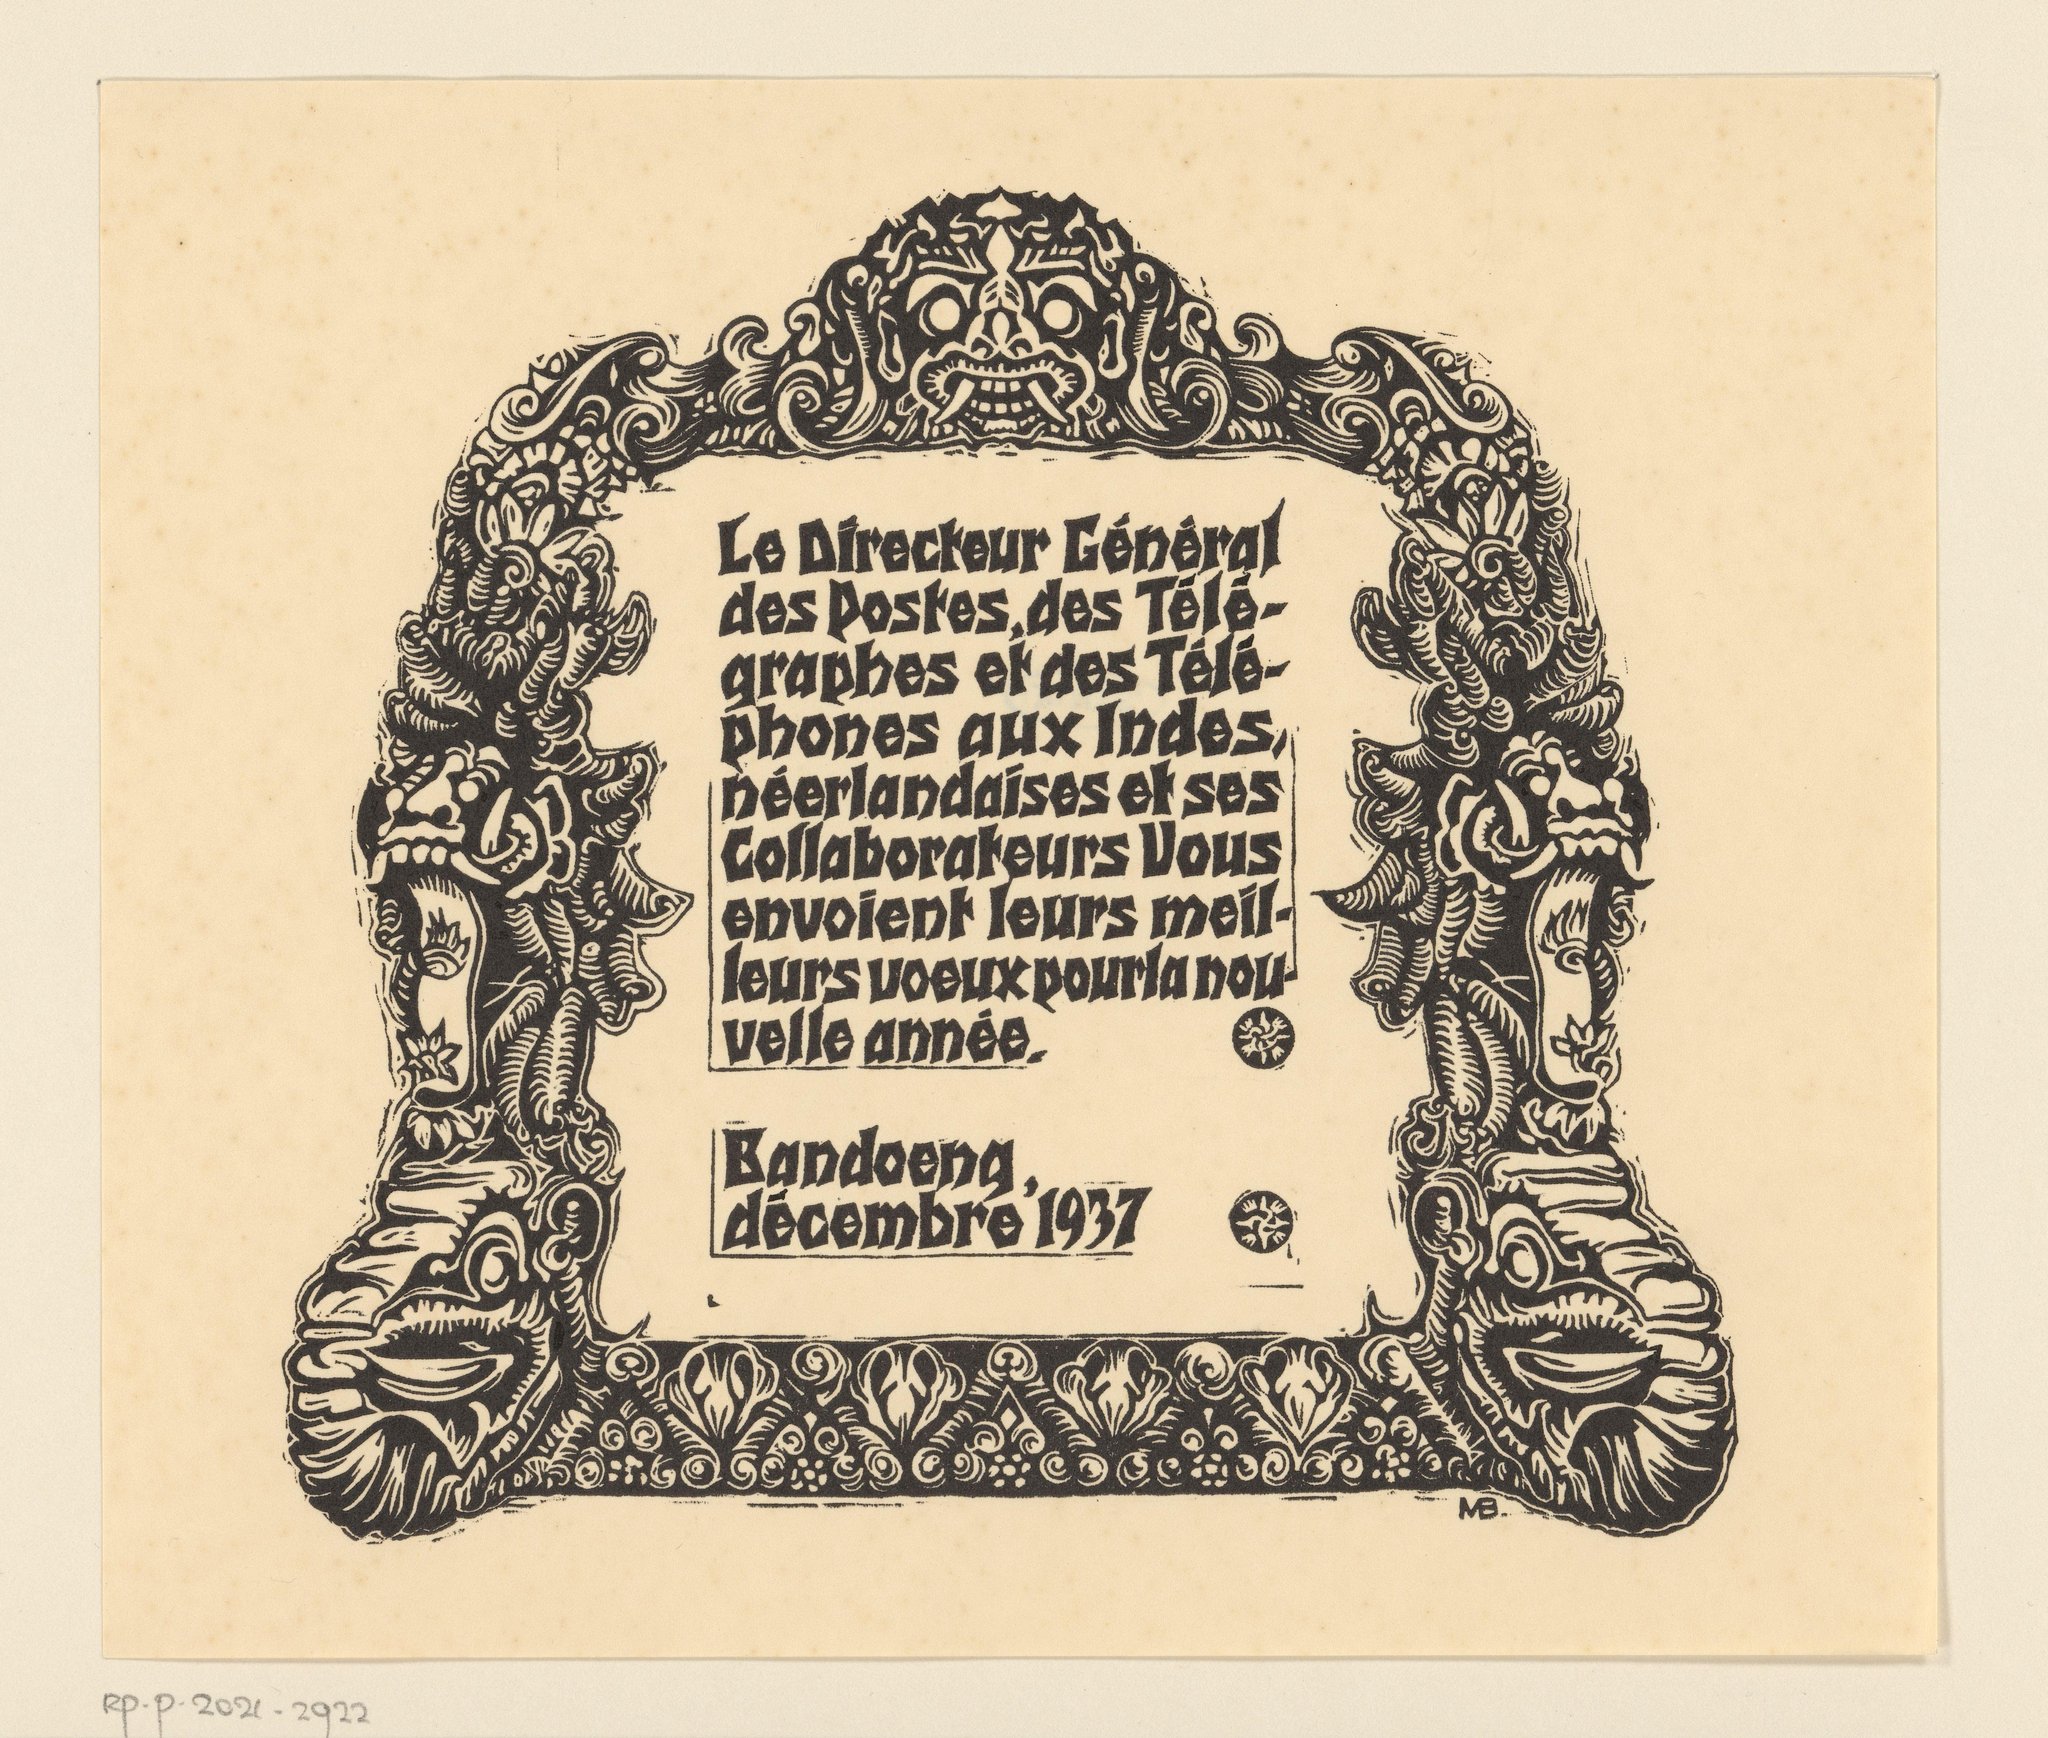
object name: print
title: Nieuwjaarswens voor 1938 van de directeur-generaal van de P.T.T. in Nederlands-Indië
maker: Anonymous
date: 1912-1937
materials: paper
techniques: woodcut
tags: mask, ornament derived from plant forms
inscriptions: collector's mark: Lugt 2228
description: Een Franstalige tekst ('Le Directeur Général des Postes, des Télégraphes et des Téléphones aux Indes néerlandaises et ses collaborateurs Vous envoient leurs meilleurs voeux pour la nouvelle année. Bandoeng, décembre 1937') in een kader met florale ornamenten en maskers.